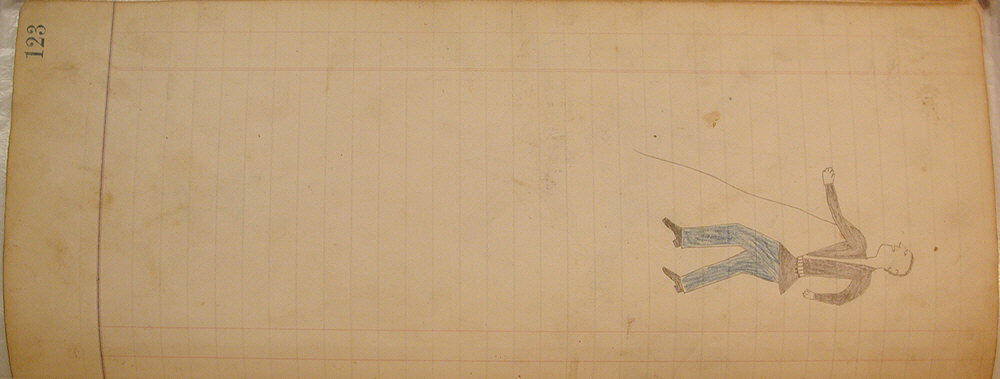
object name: drawing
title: Maffet Ledger: Drawing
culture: cheyenne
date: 1874-1881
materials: crayon, graphite, paper, watercolor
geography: united states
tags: men